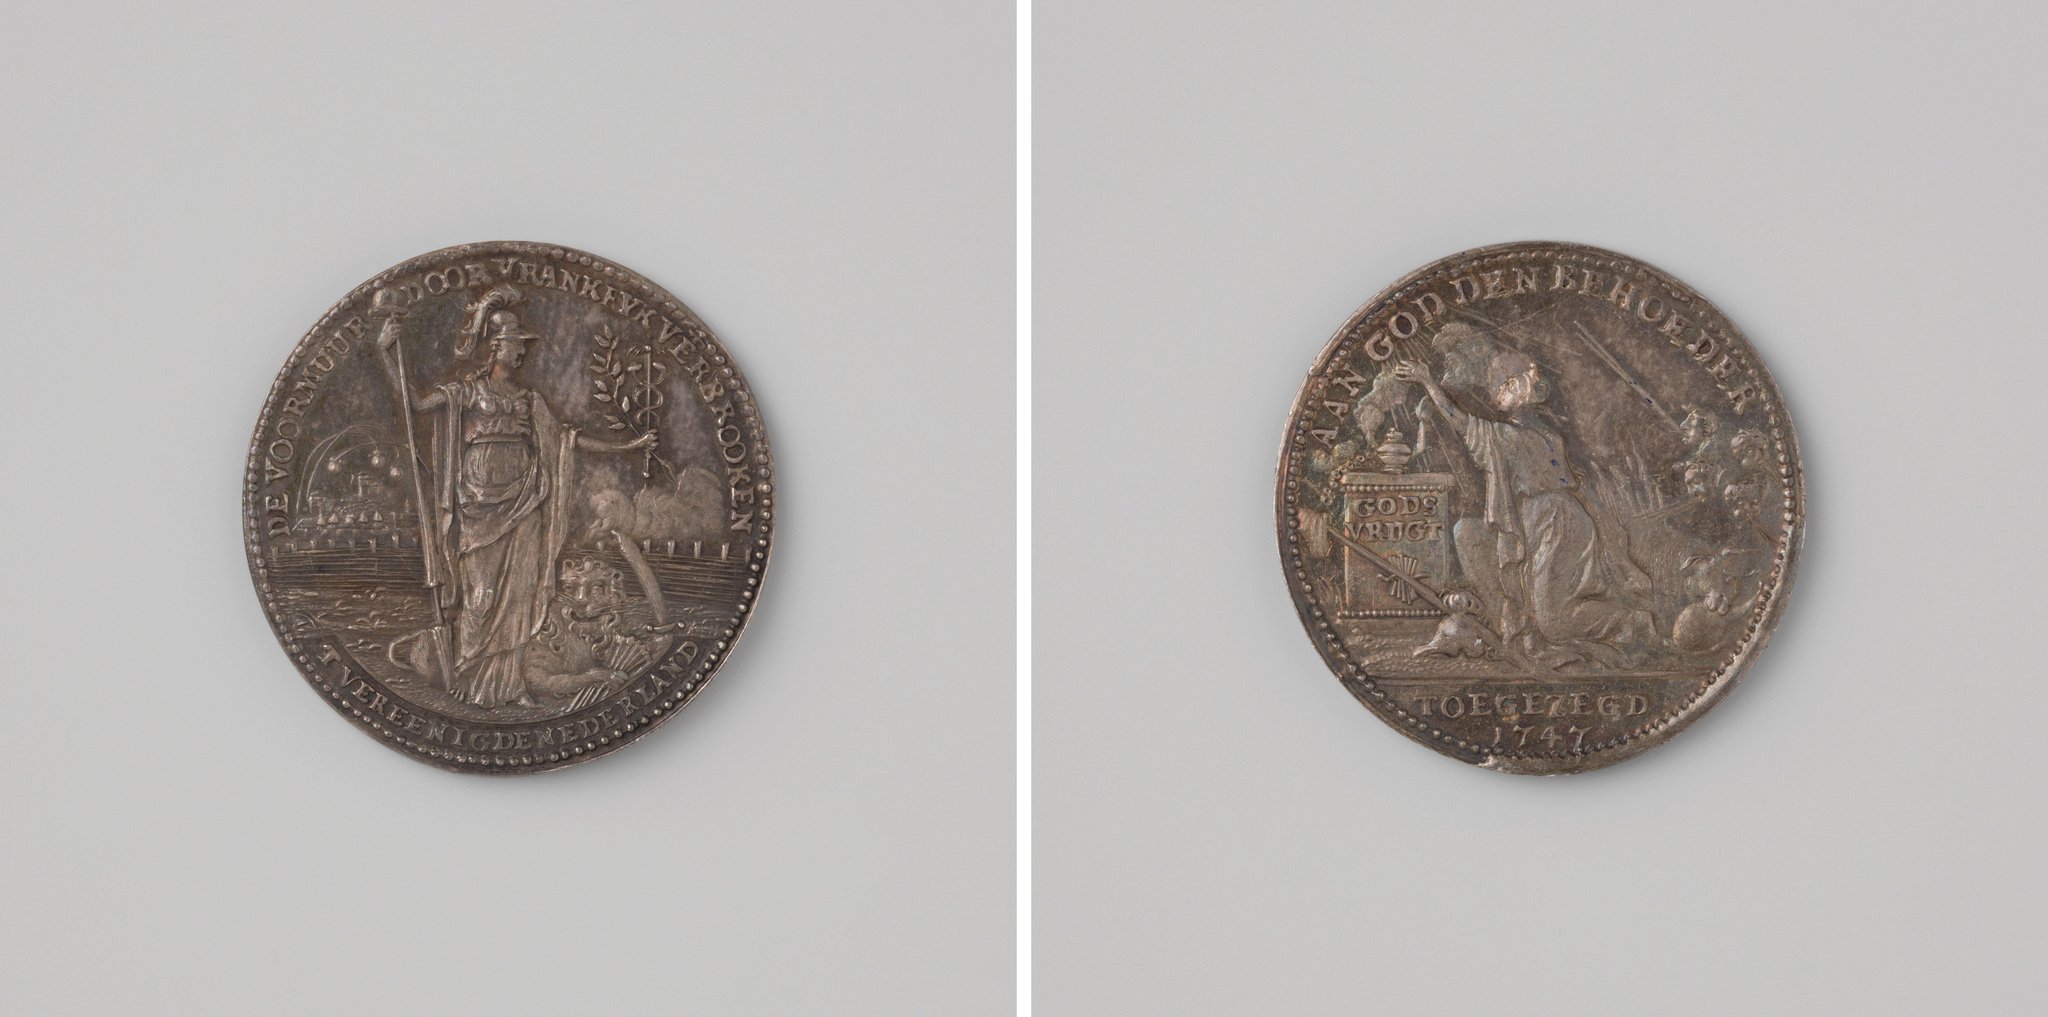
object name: new year medal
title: Aanvang van het jaar 1747, op het verbreken van het Barriere-verdrag door de Fransen en op de hoop op vrede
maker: martinus holtzhey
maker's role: medailleur, muntmaker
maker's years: 1697-1764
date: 1746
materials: silver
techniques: striking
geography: amsterdam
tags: oostenrijkse successieoorlog